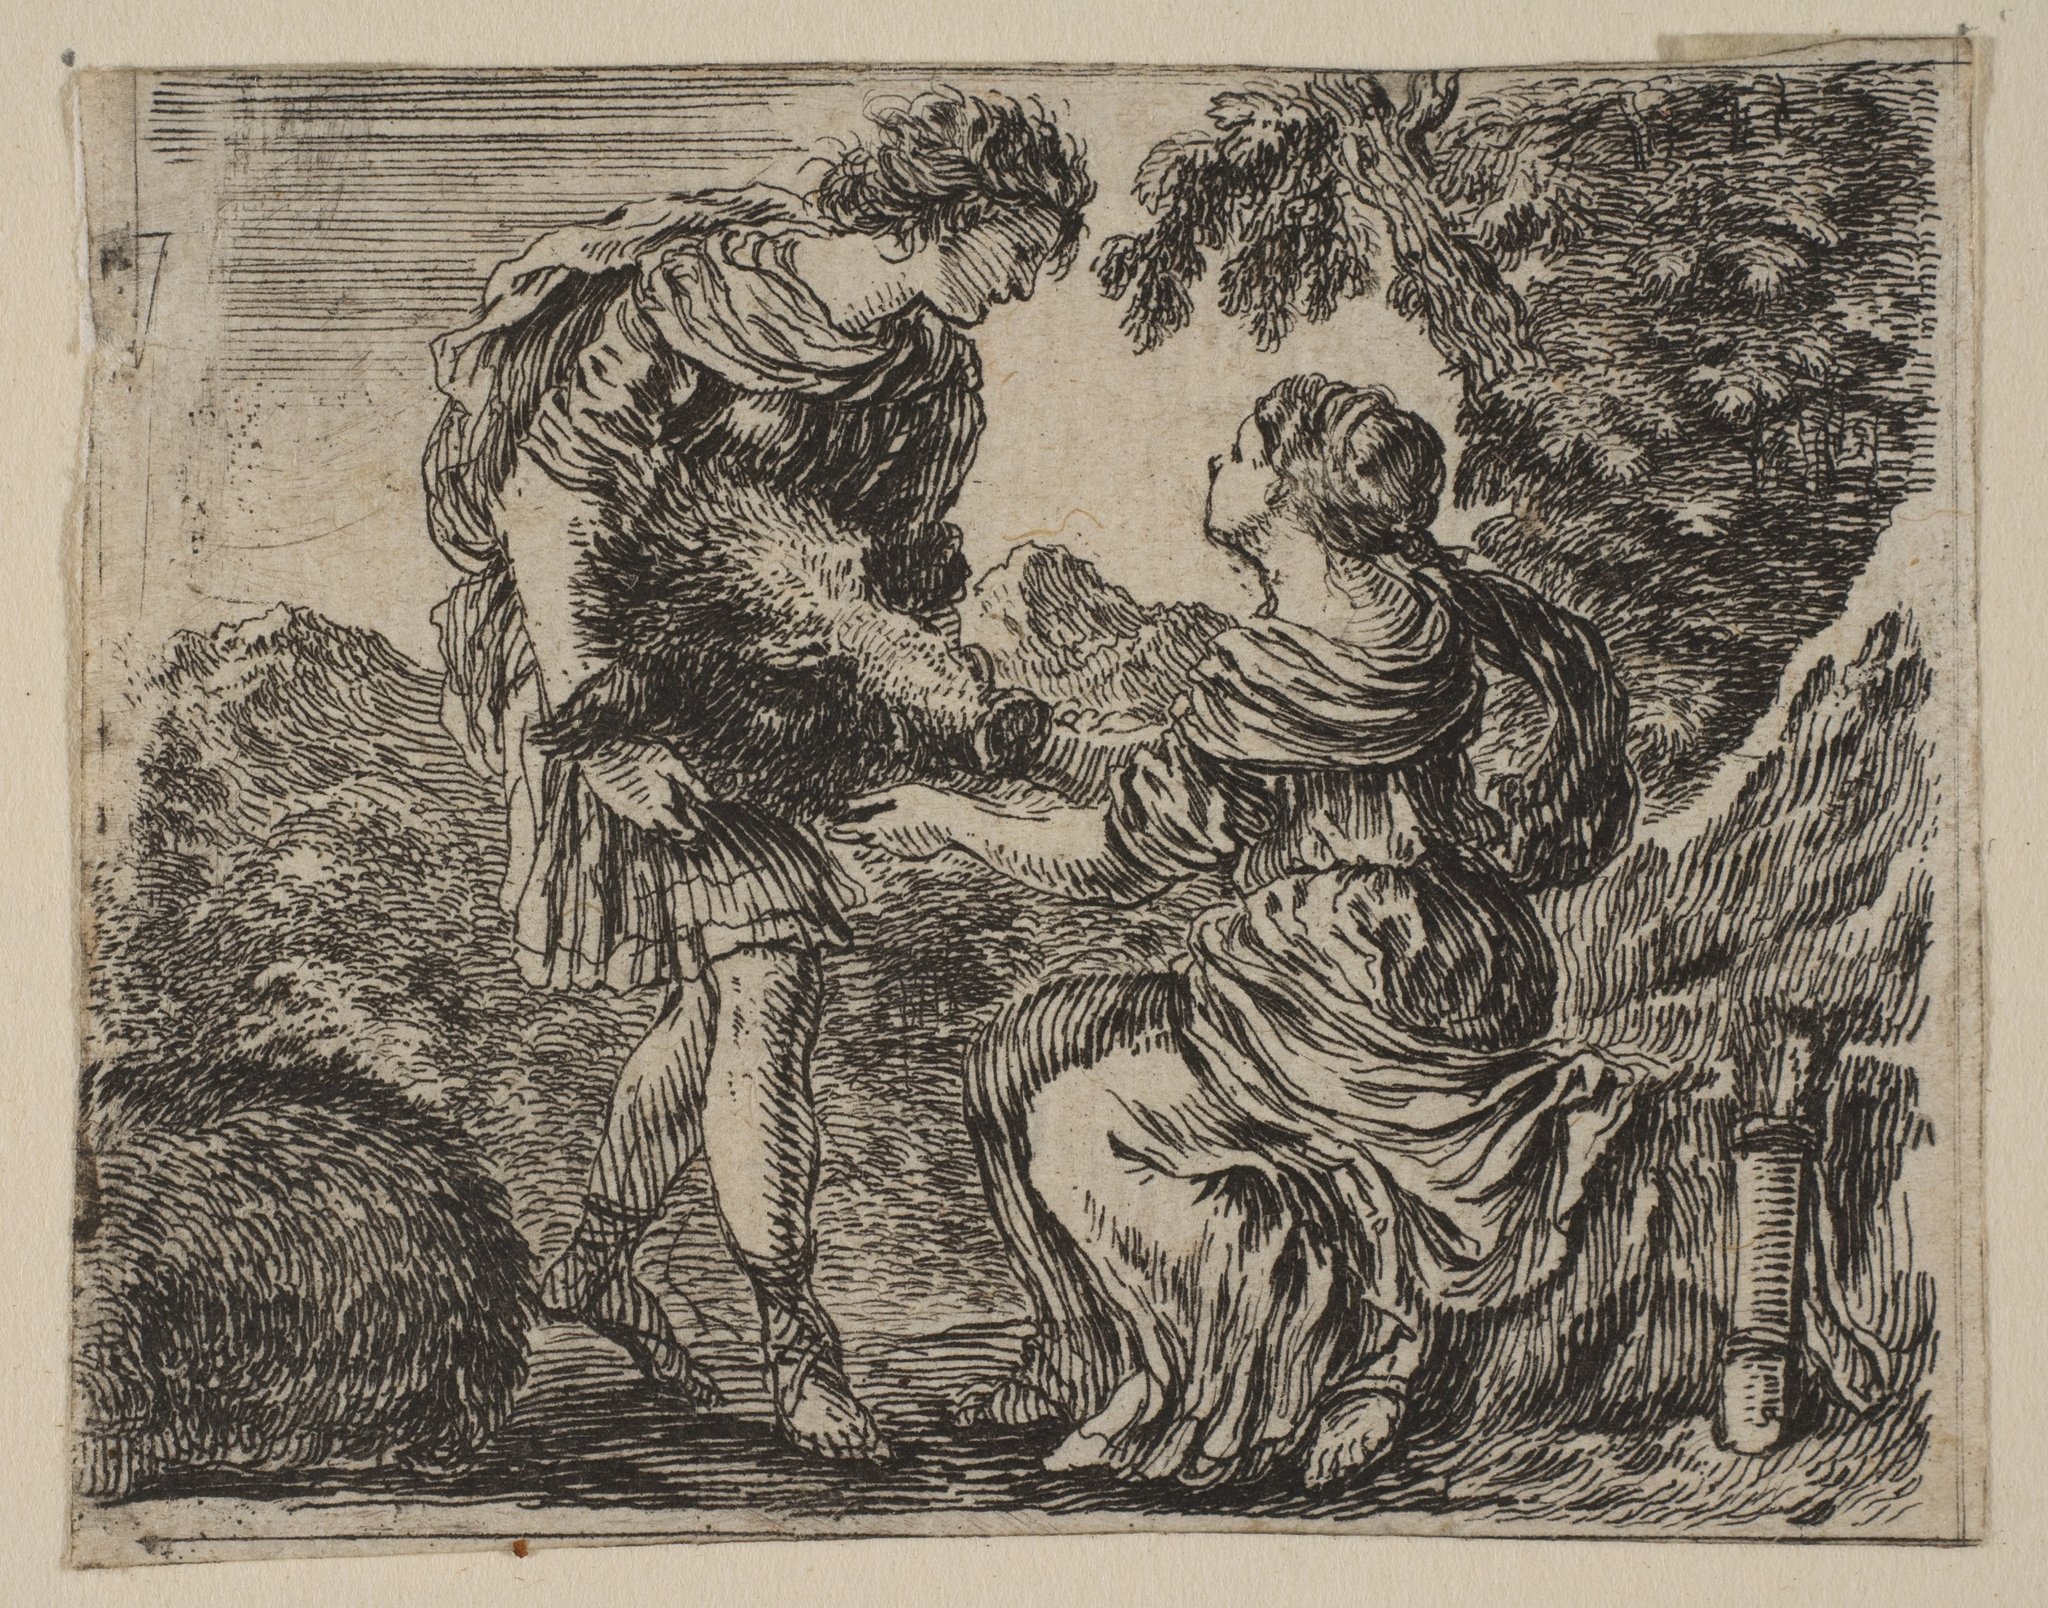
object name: print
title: Meleager and Atalanta, from 'Game of Mythology' (Jeu de la Mythologie)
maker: stefano della bella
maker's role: artist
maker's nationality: italian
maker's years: 1610-1664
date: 1644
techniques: etching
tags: men,women